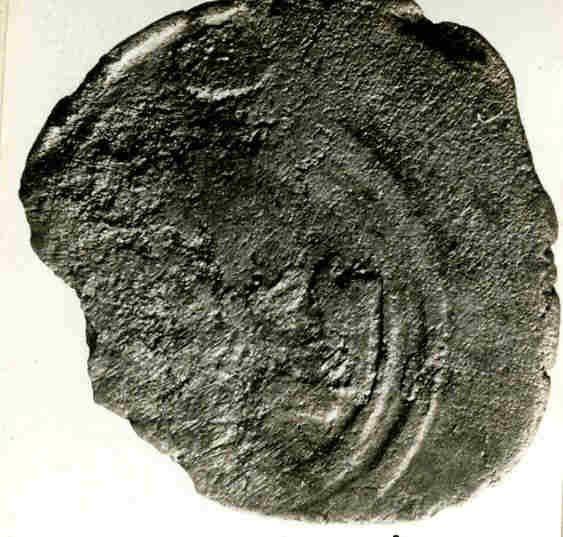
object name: coin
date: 1067-1233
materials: copper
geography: iran